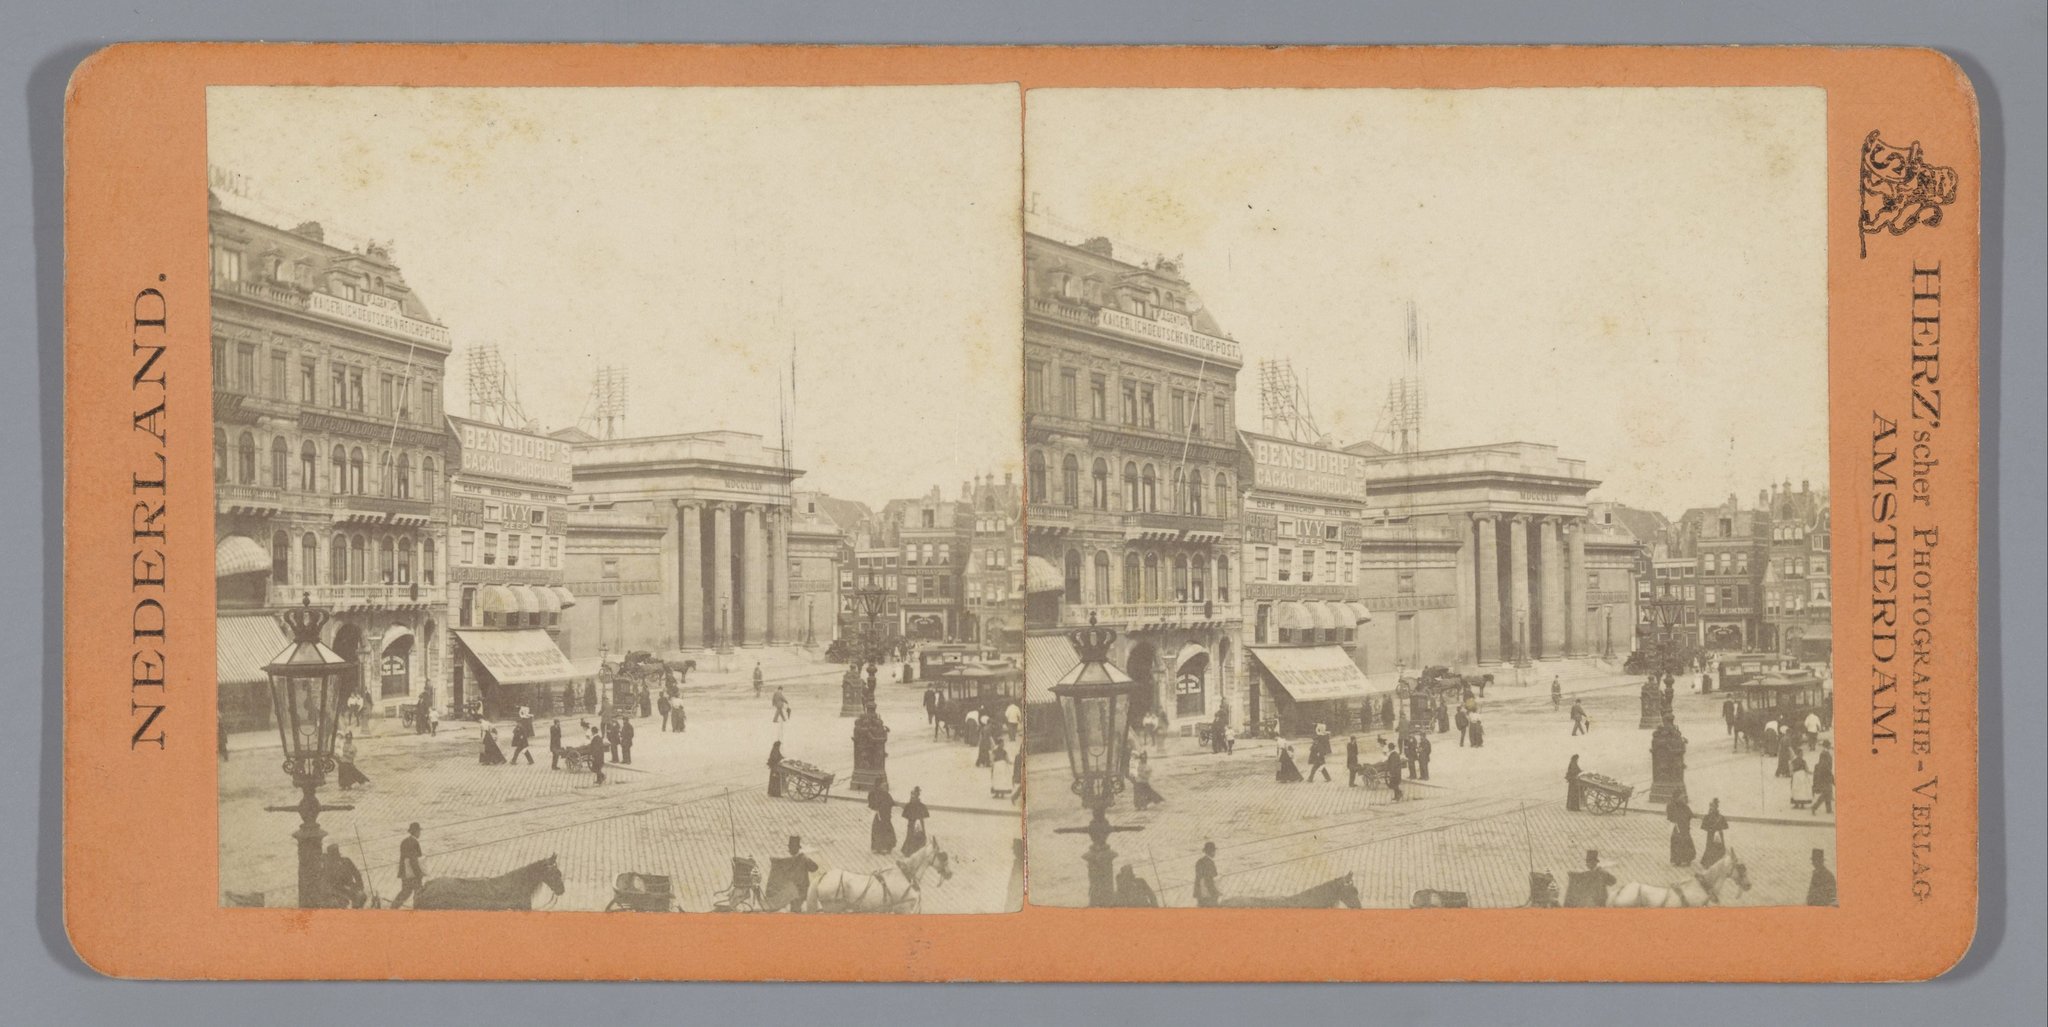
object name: stereograph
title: Dam en de Beurs van Zocher, Amsterdam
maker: sigmund löw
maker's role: publisher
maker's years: 1845-1920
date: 1892-1902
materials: cardboard, paper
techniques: albumen print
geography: amsterdam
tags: square, place, circus, etc., stock exchange, stock-market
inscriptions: inscription: ‘Amsterdam./ Dam met Beurs’